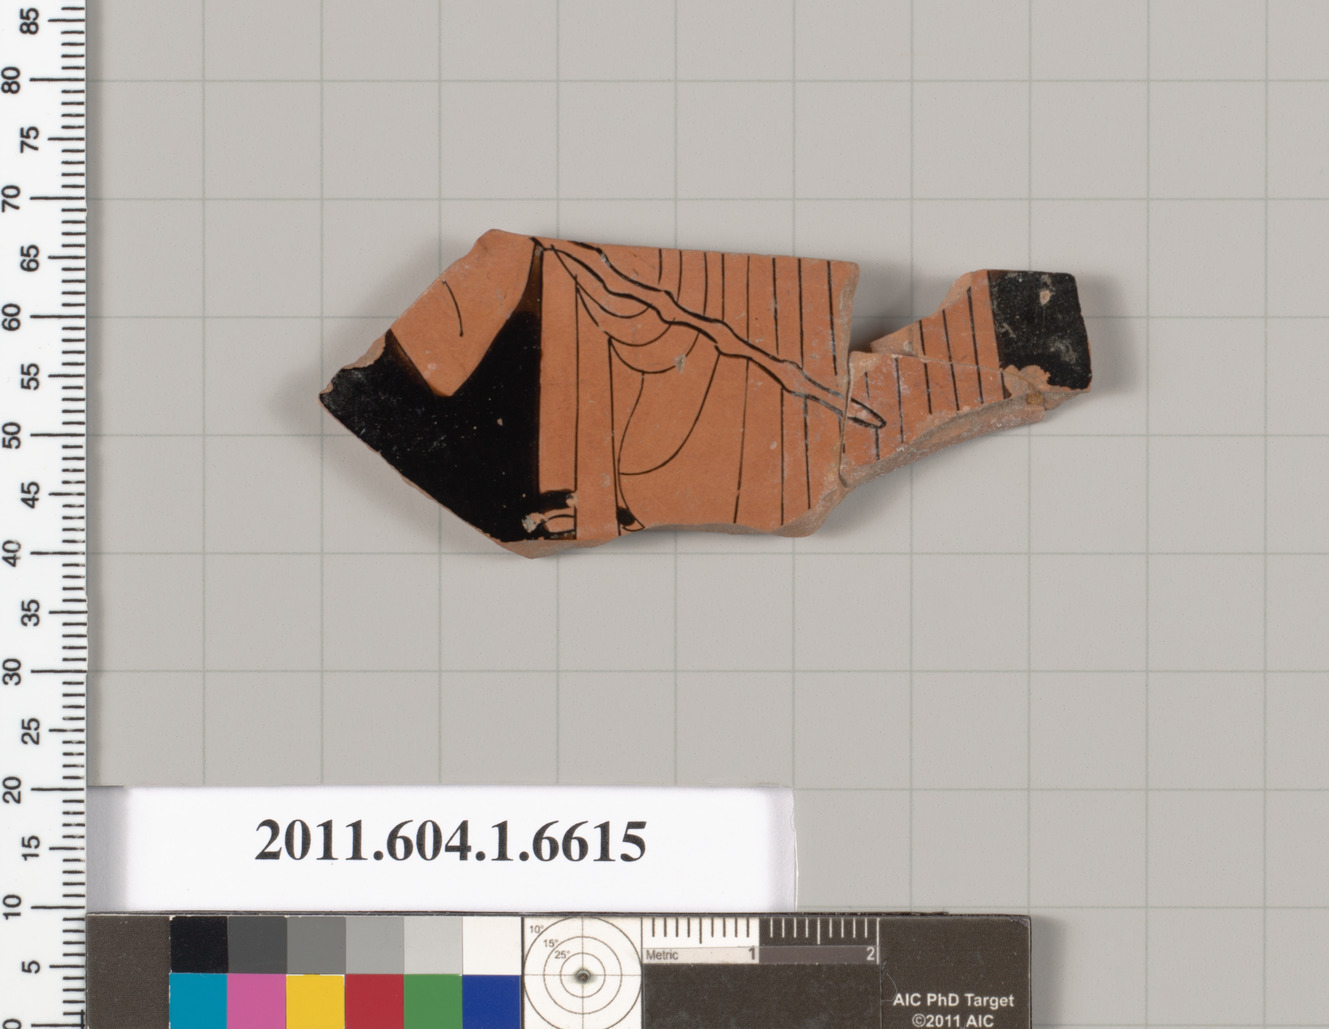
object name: kylix fragment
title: Terracotta fragment of a kylix (drinking cup)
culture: greek, attic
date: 490-470 BCE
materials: terracotta